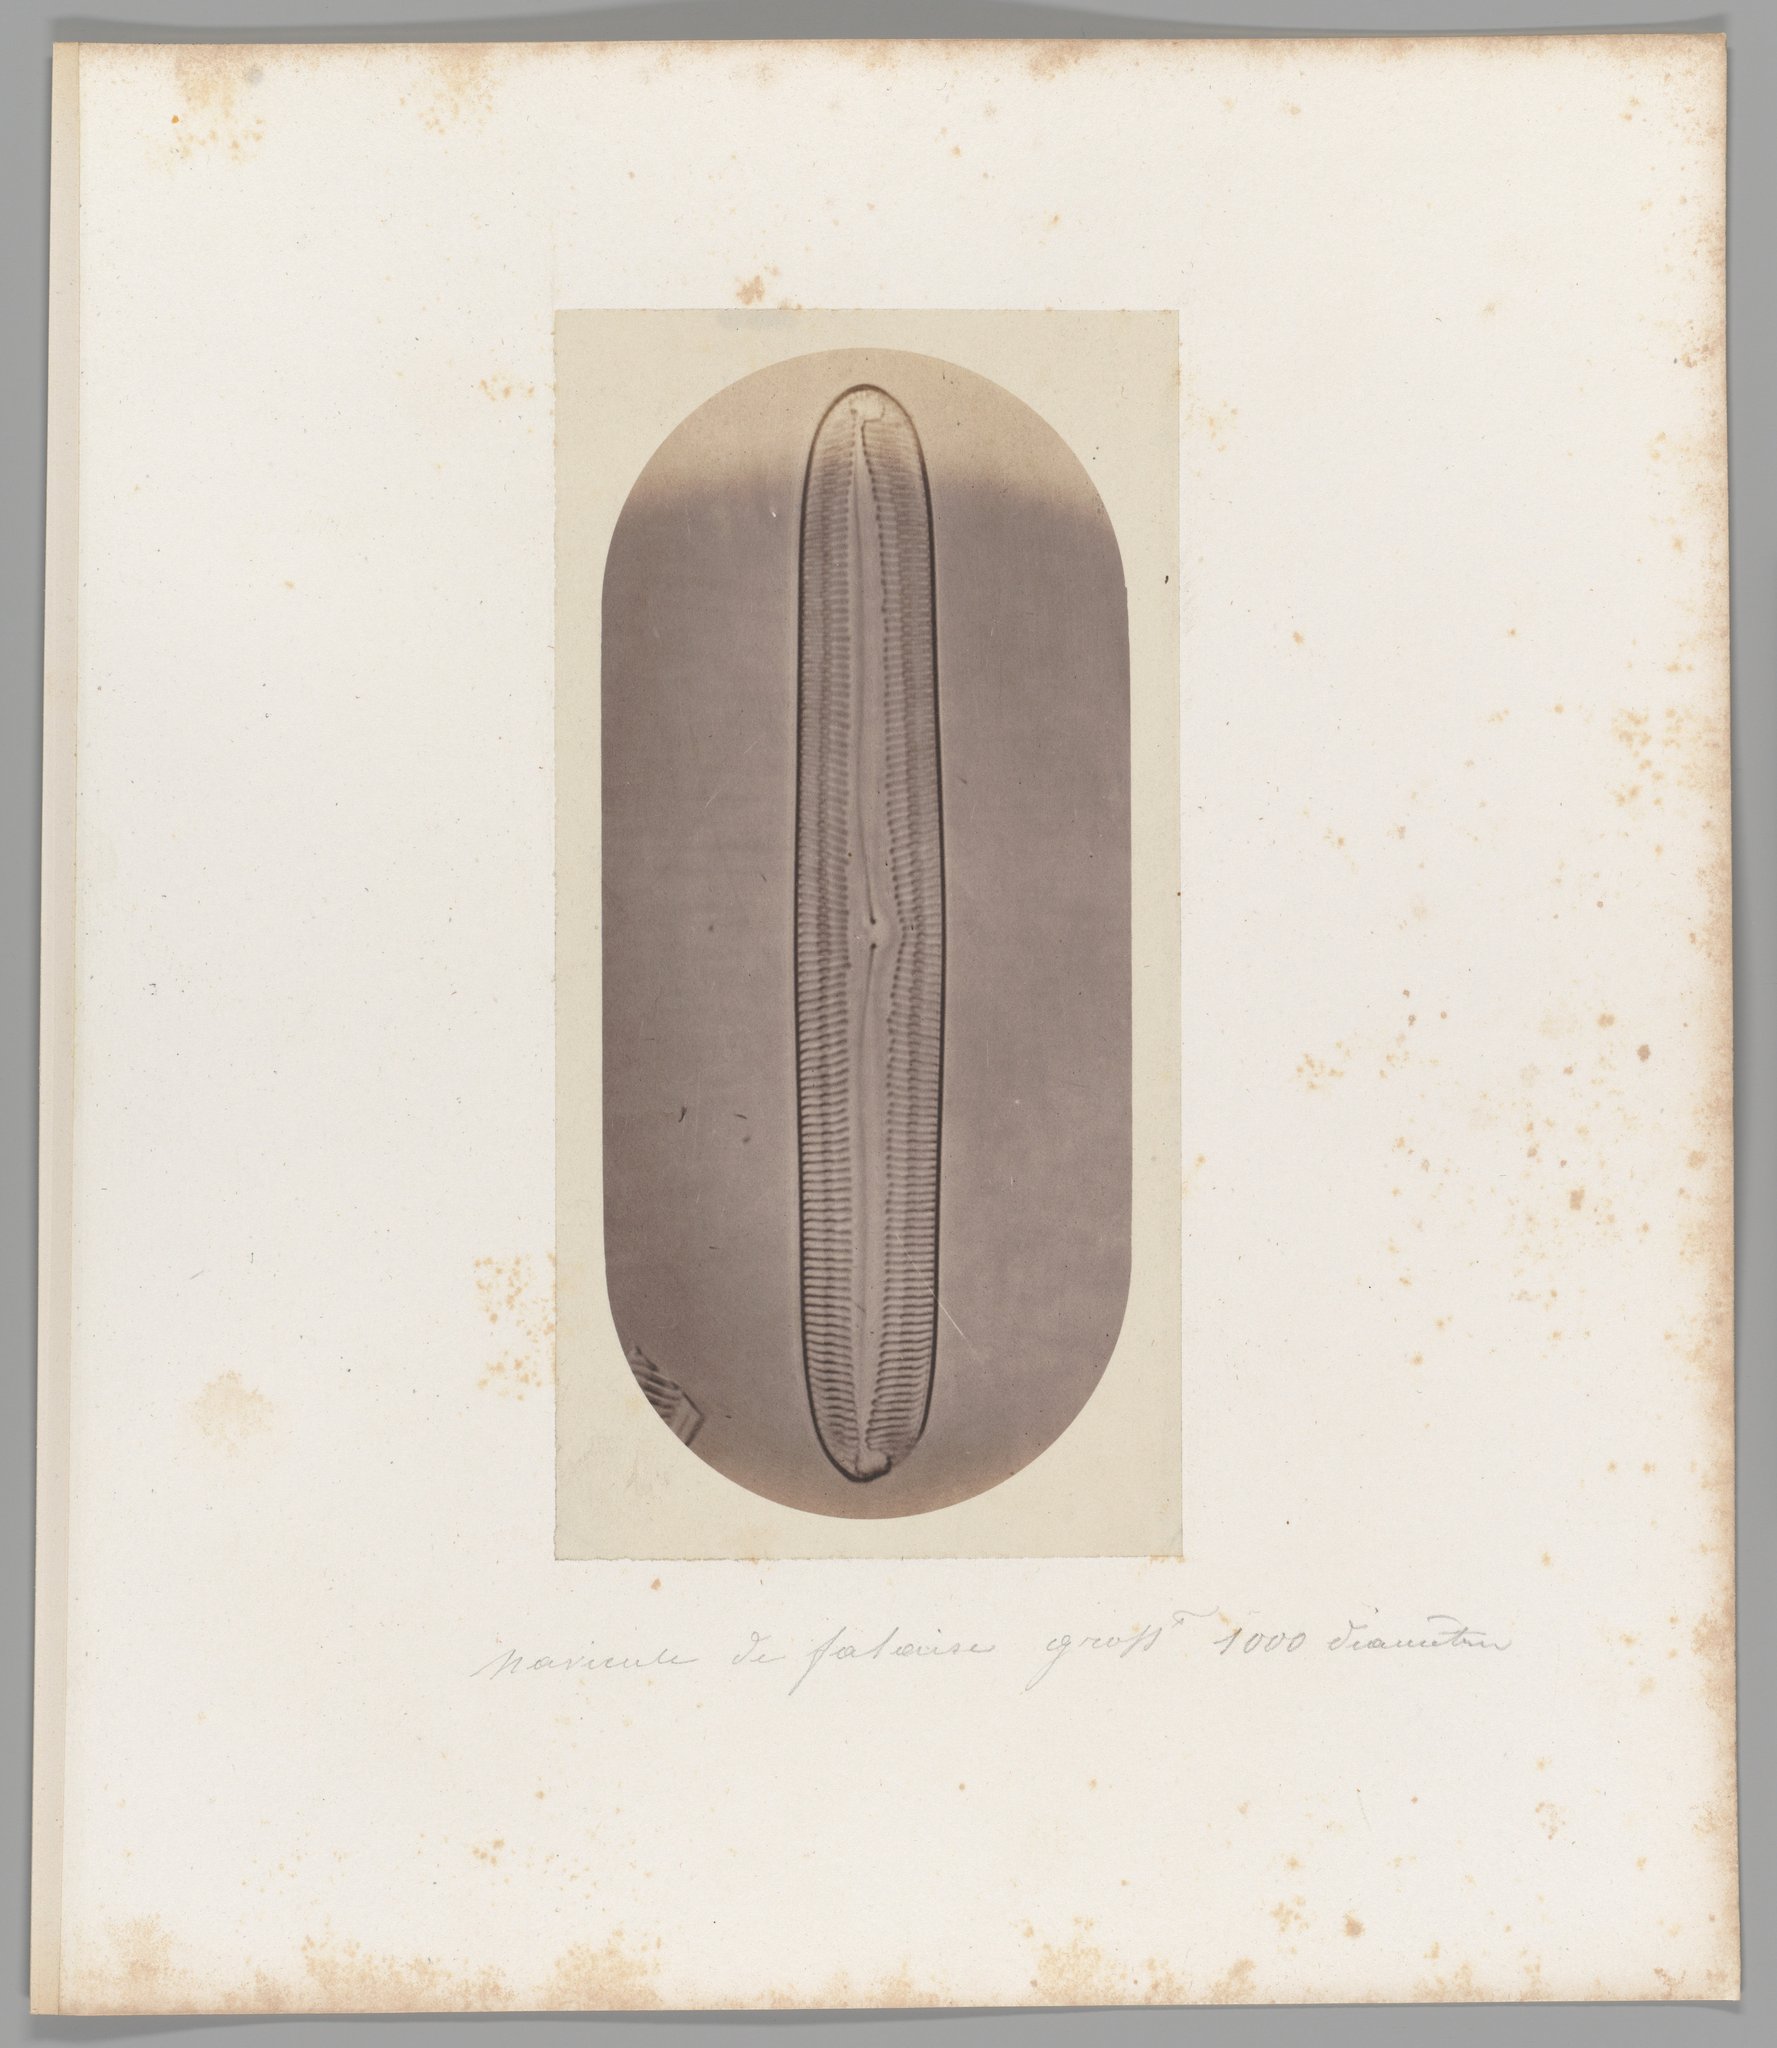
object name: photograph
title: [Untitled]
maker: auguste-adolphe bertsch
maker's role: artist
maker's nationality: french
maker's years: 1813-1871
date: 1853-1857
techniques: salted paper print